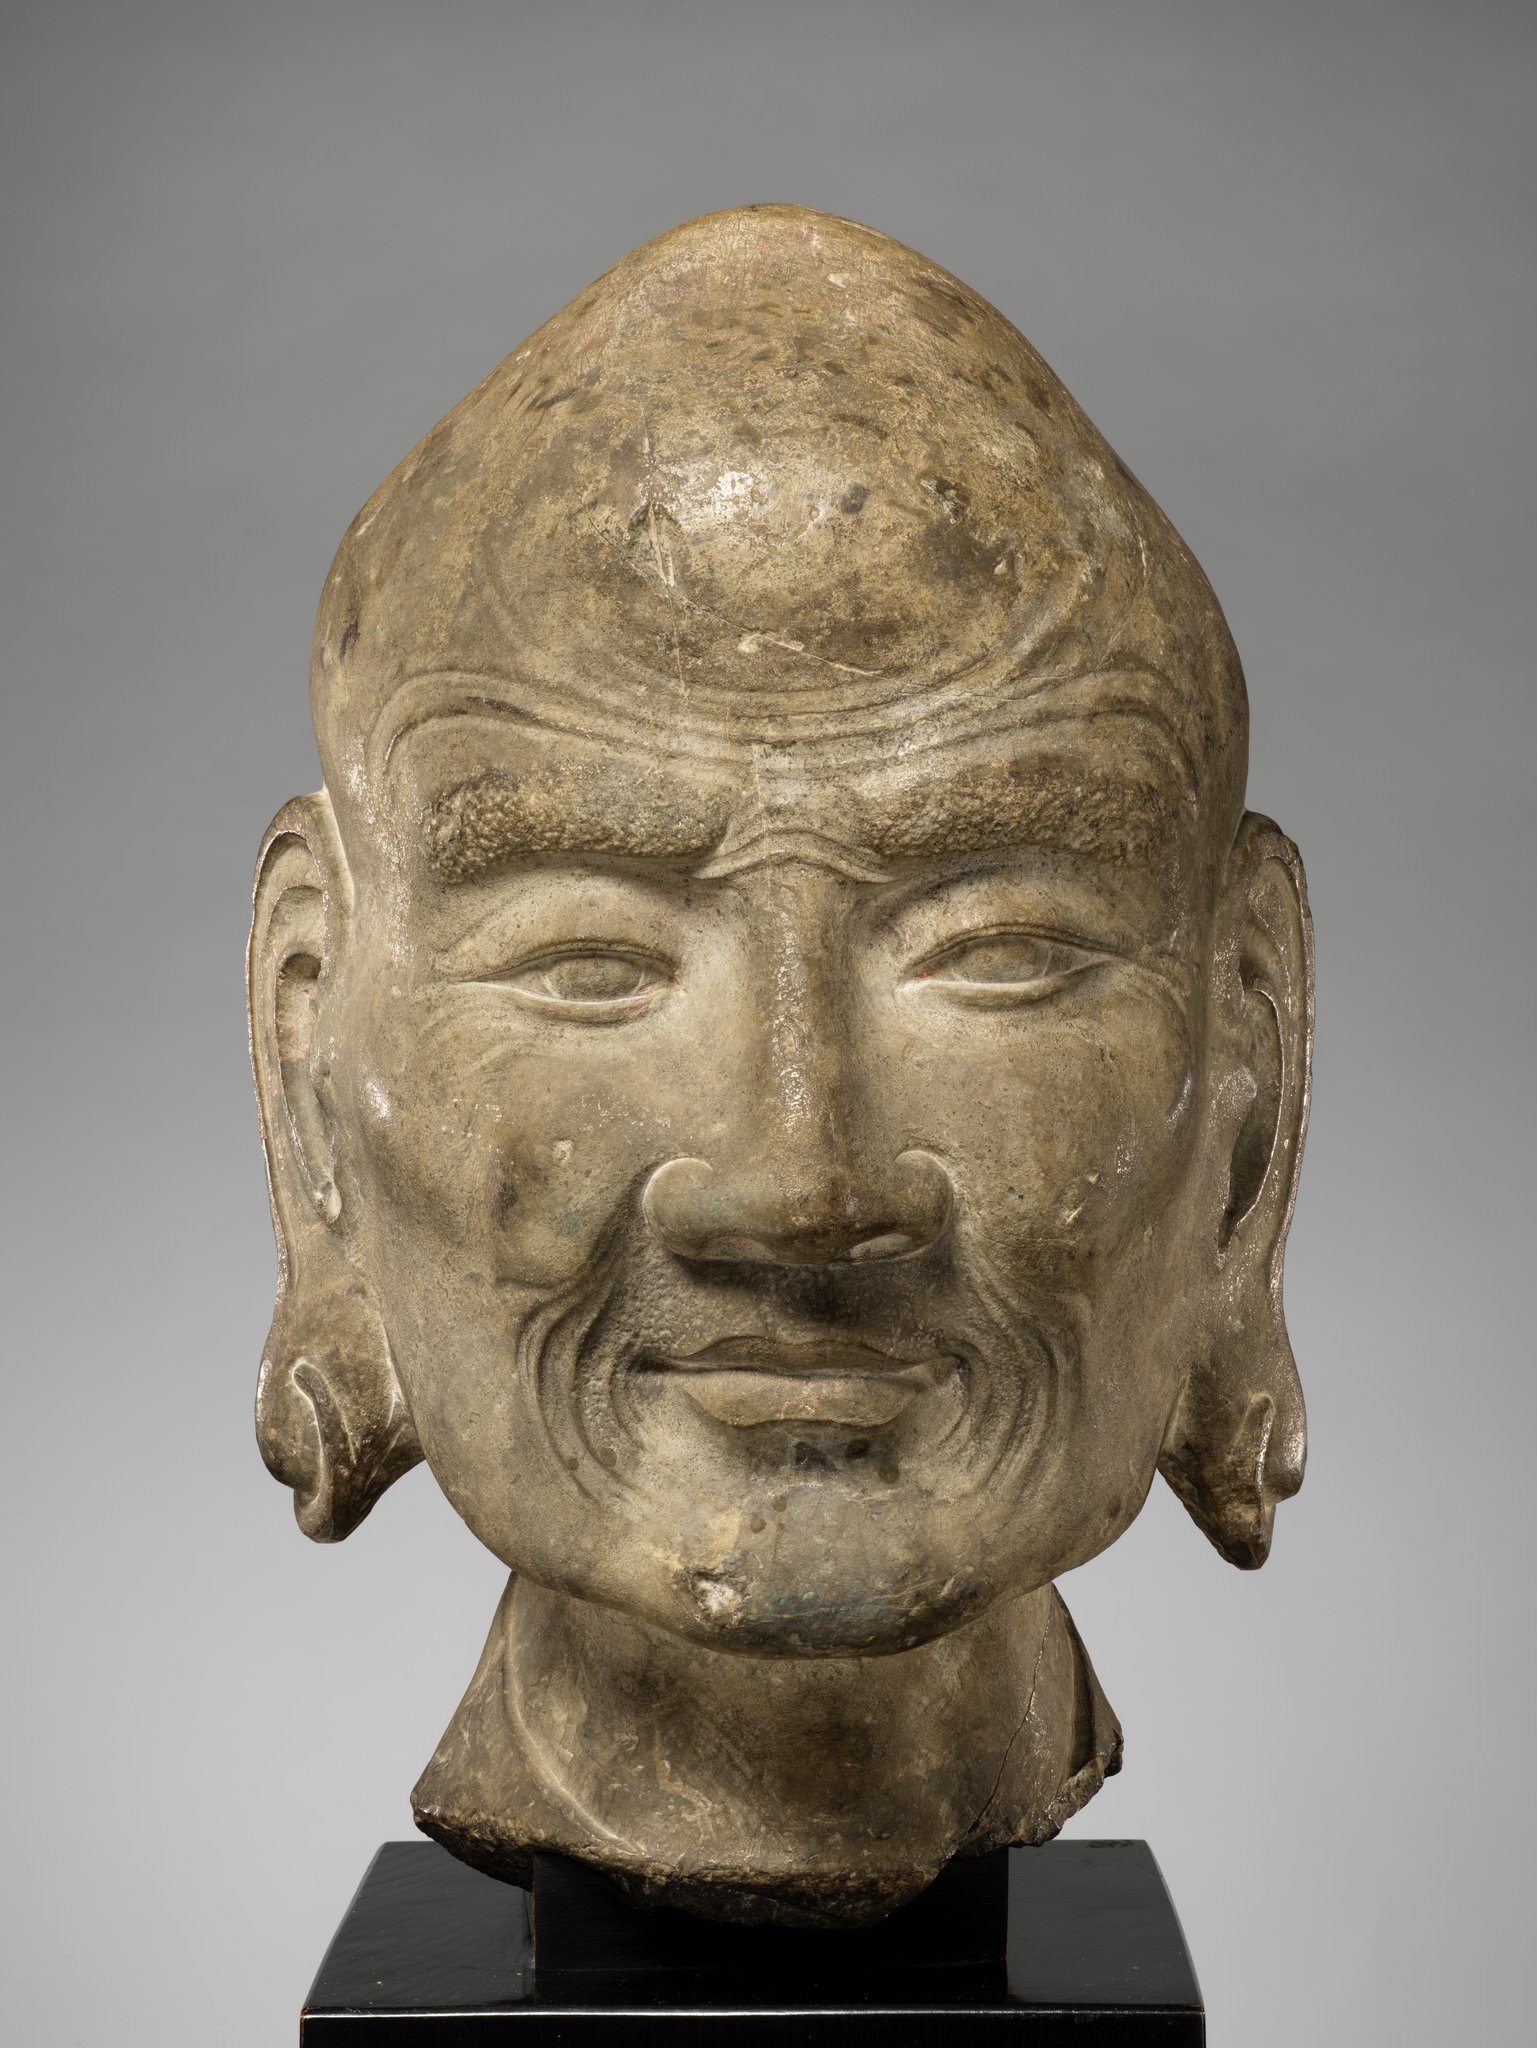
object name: head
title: Head of Luohan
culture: chinese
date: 1368-1644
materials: limestone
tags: heads